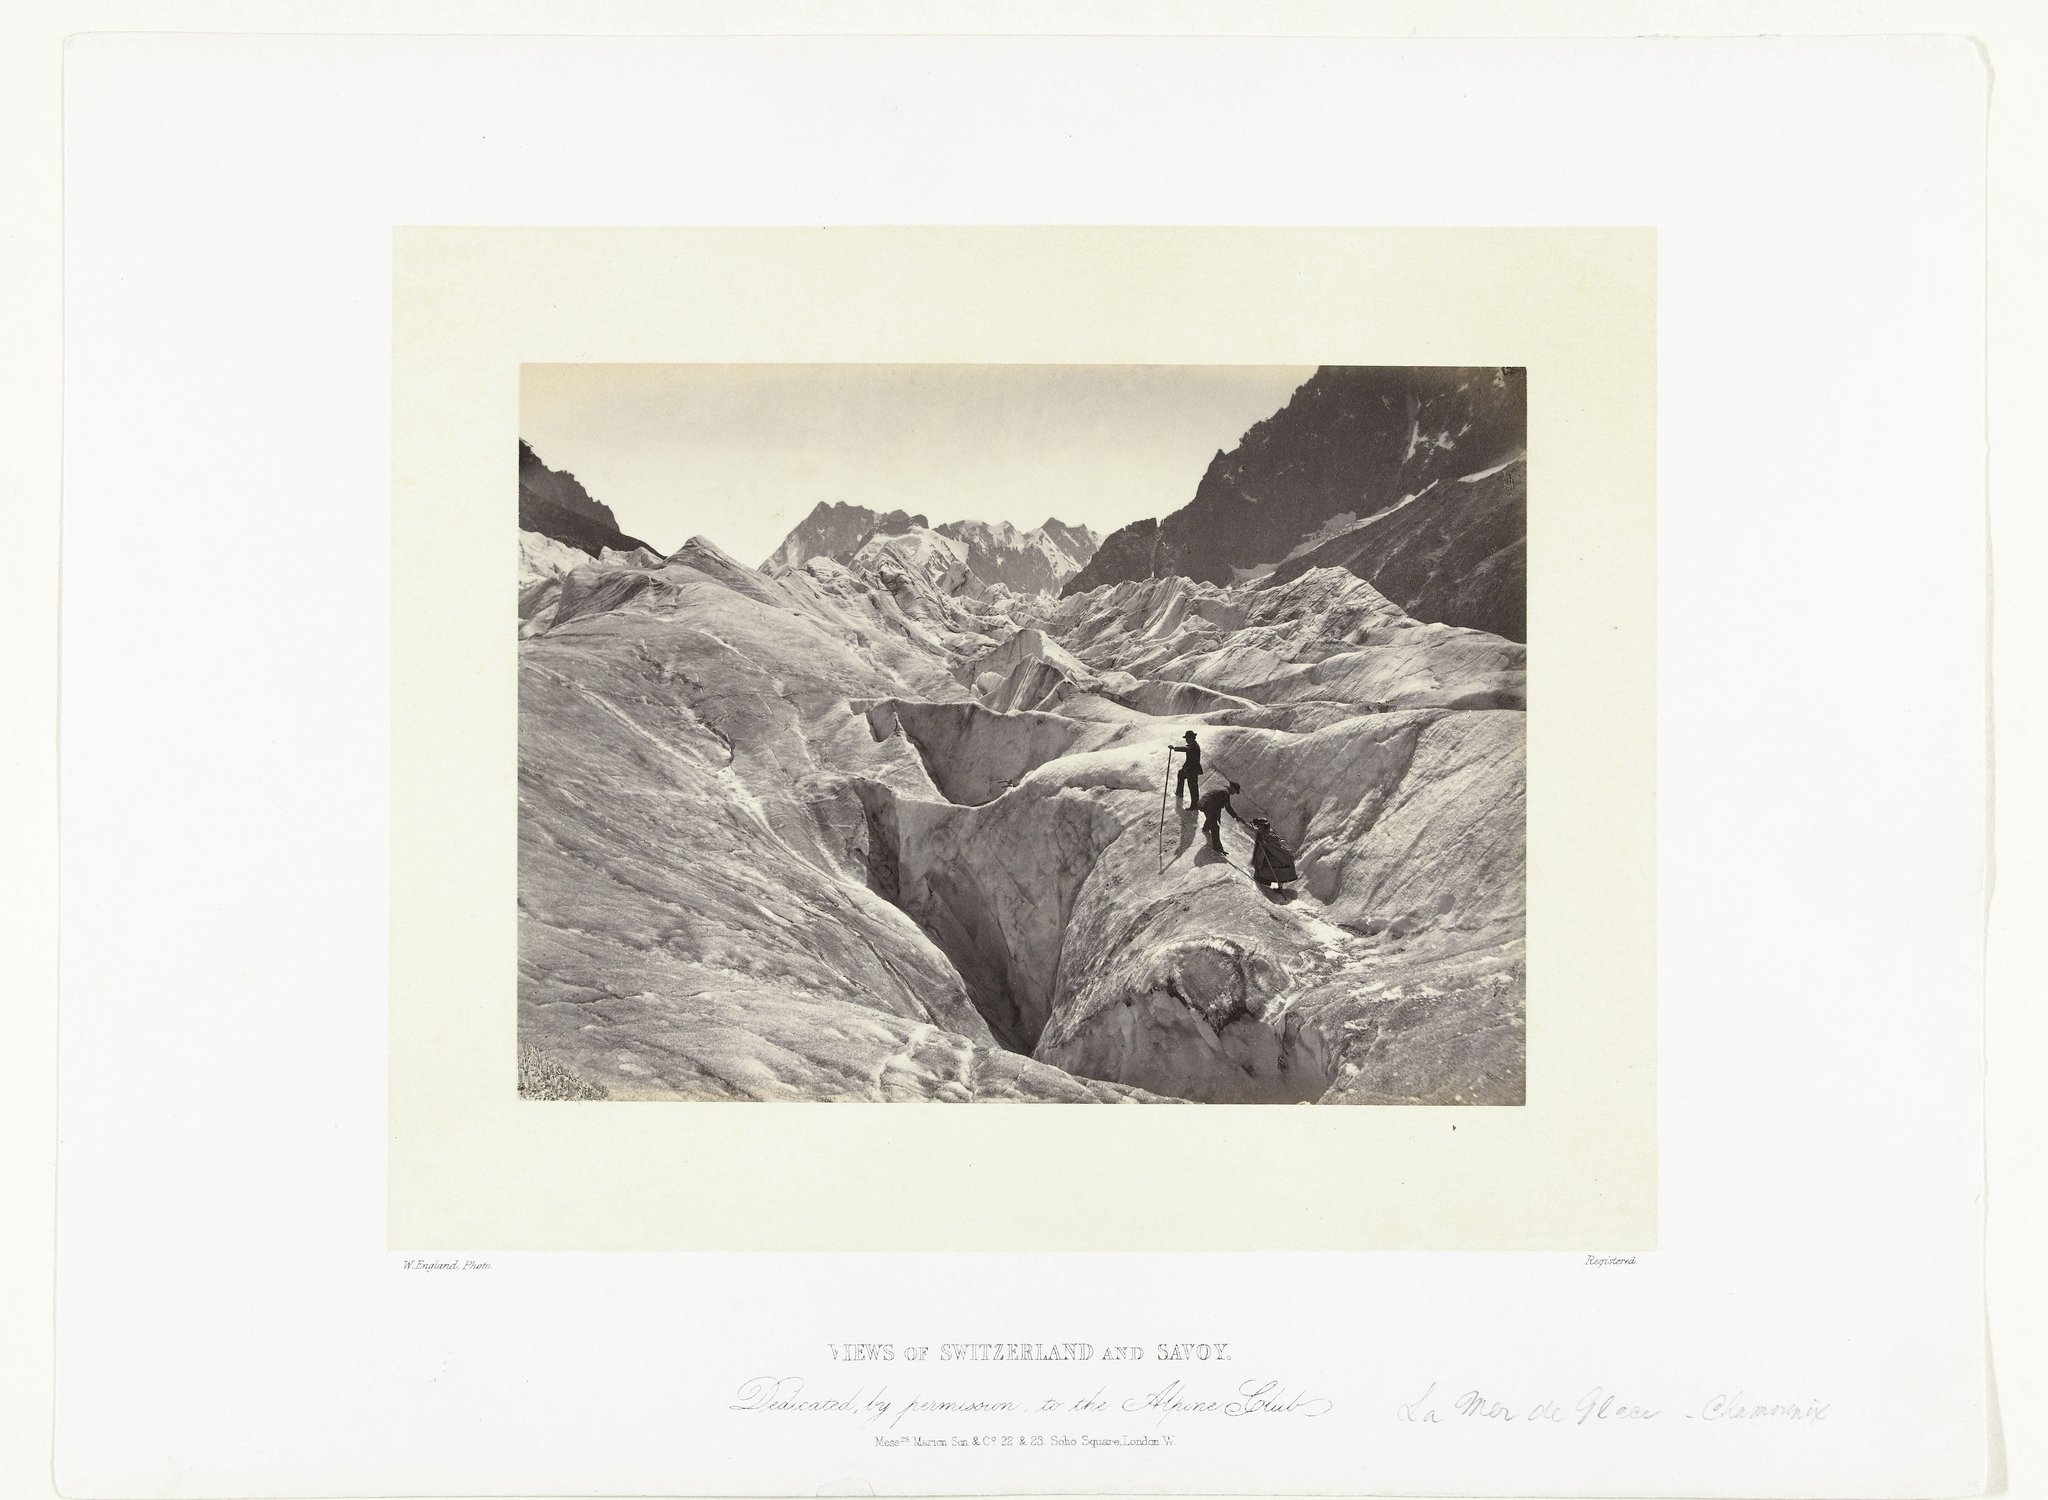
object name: photograph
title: La Mer de Glace - Chamonix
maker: william england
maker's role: fotograaf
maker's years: 1816-1896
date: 1863-1865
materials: cardboard, paper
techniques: albumen print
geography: mer de glace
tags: glacier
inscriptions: inscription: ‘Registered’, inscription: ‘Dedicated, by permission, to the Alpine Club’, address: ‘Messrs Marion & Co 22 & 23 Soho Square, London W.’